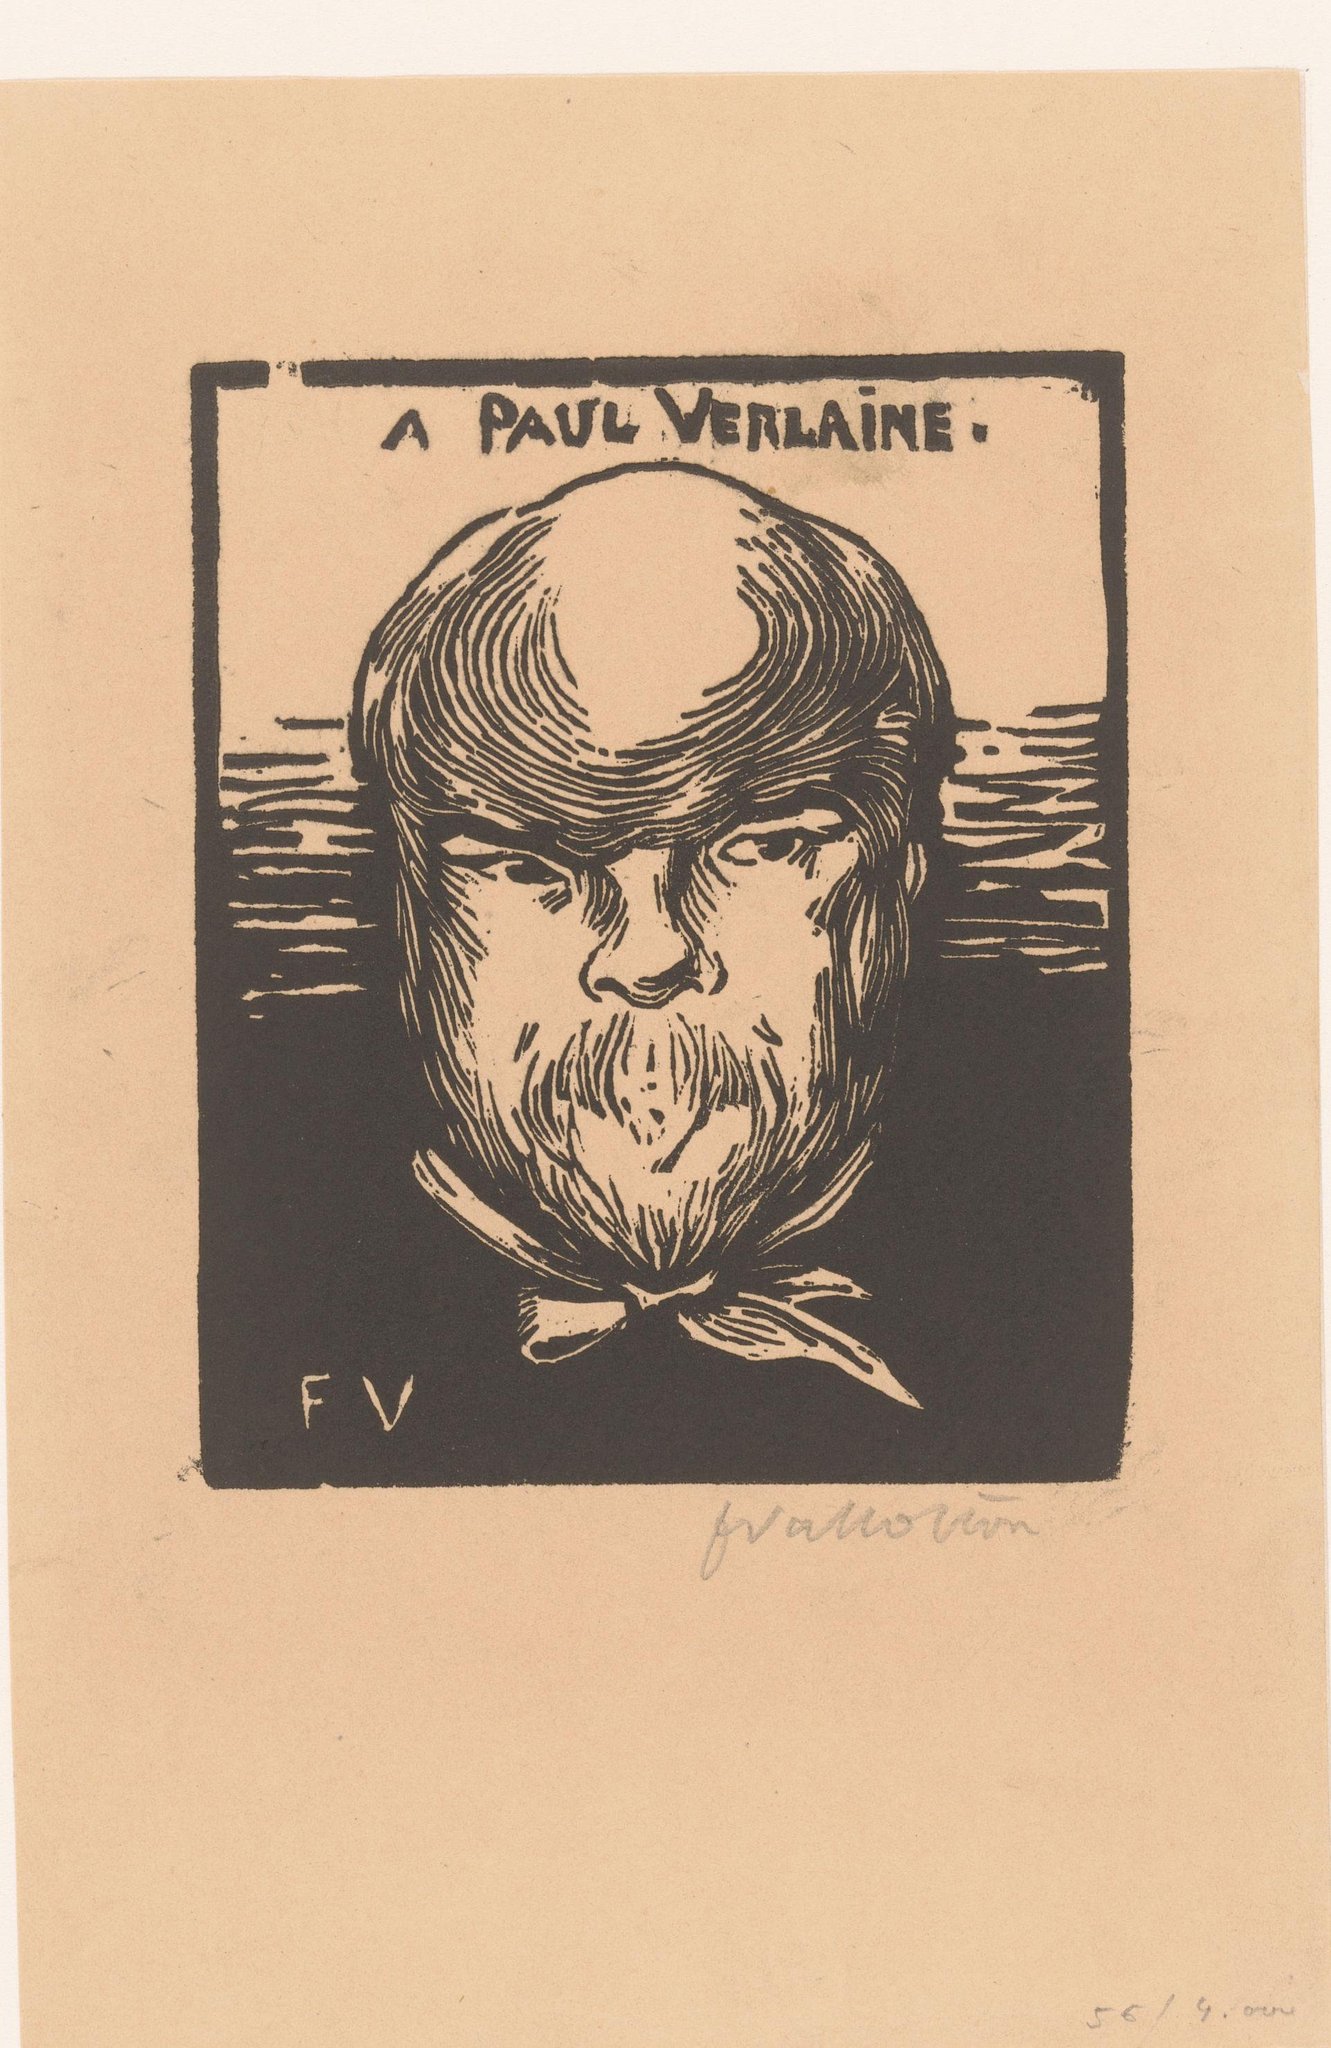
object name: print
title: Portret van Paul Verlaine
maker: félix edouard vallotton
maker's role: print maker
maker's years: 1865-1925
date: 1891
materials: paper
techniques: woodcut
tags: paris, paul verlaine, historical persons, portrait of a writer, writer, poet, author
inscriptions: collector's mark: Lugt 2228, collector's mark: Lugt 2760